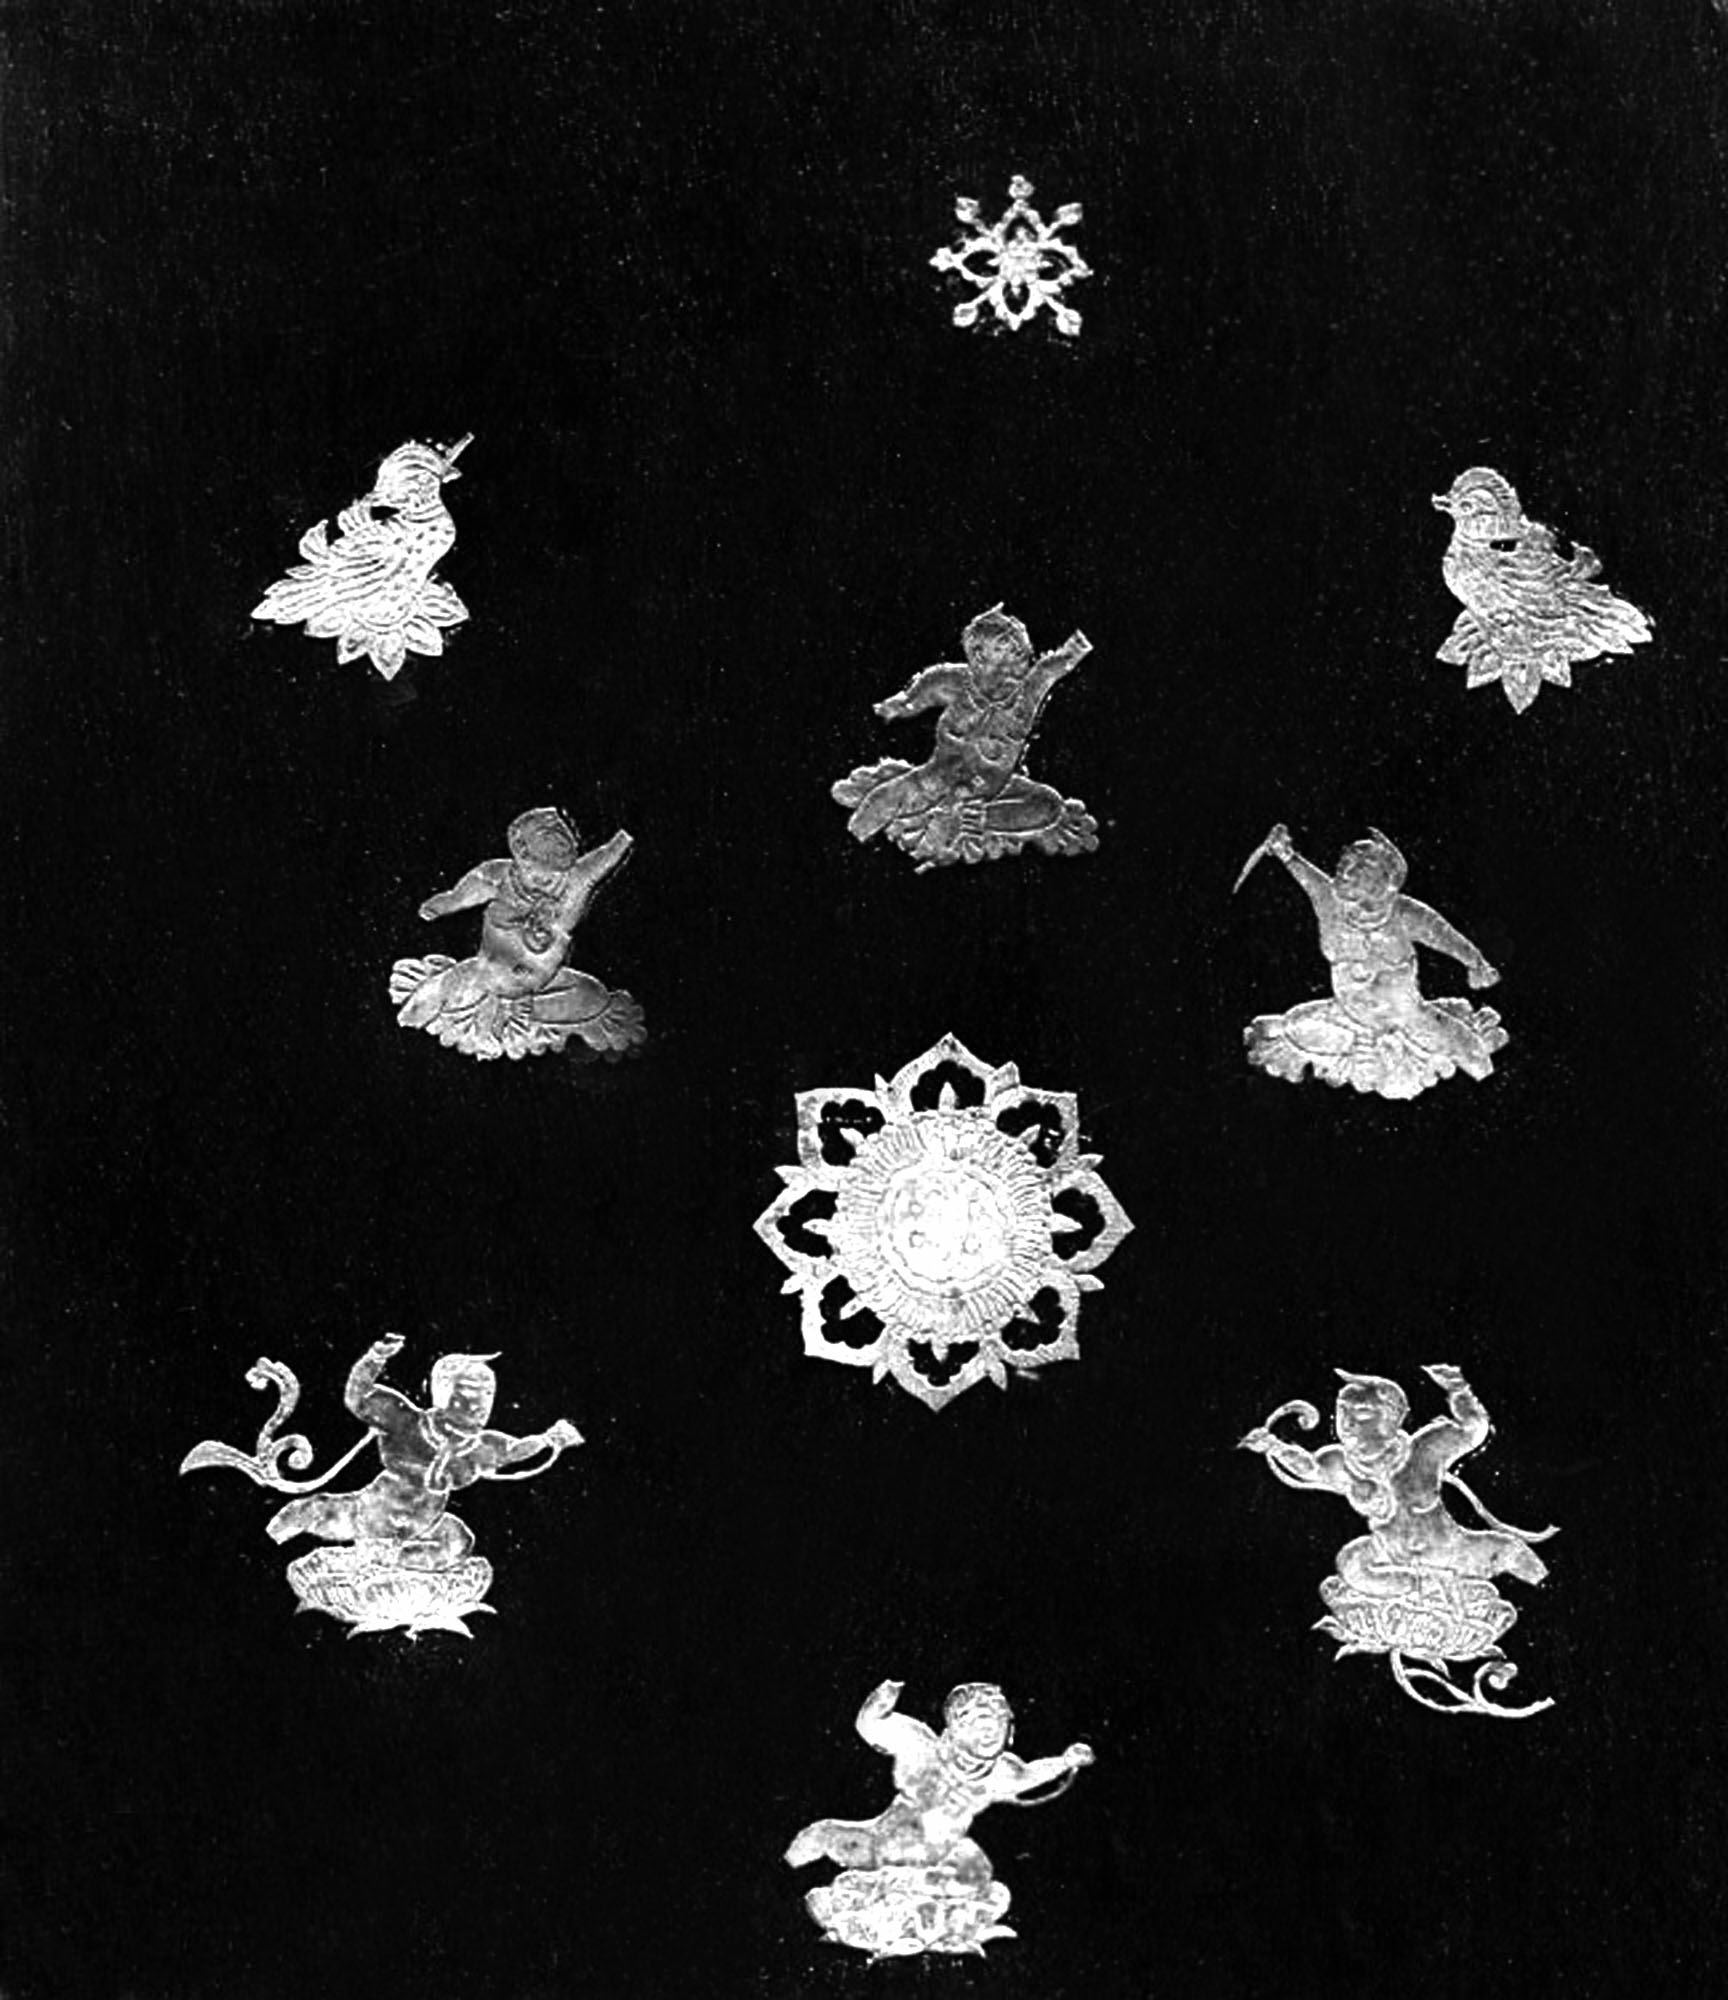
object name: inlay piece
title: Ten pieces of inlay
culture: chinese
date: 618-907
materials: silver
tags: mythical creatures